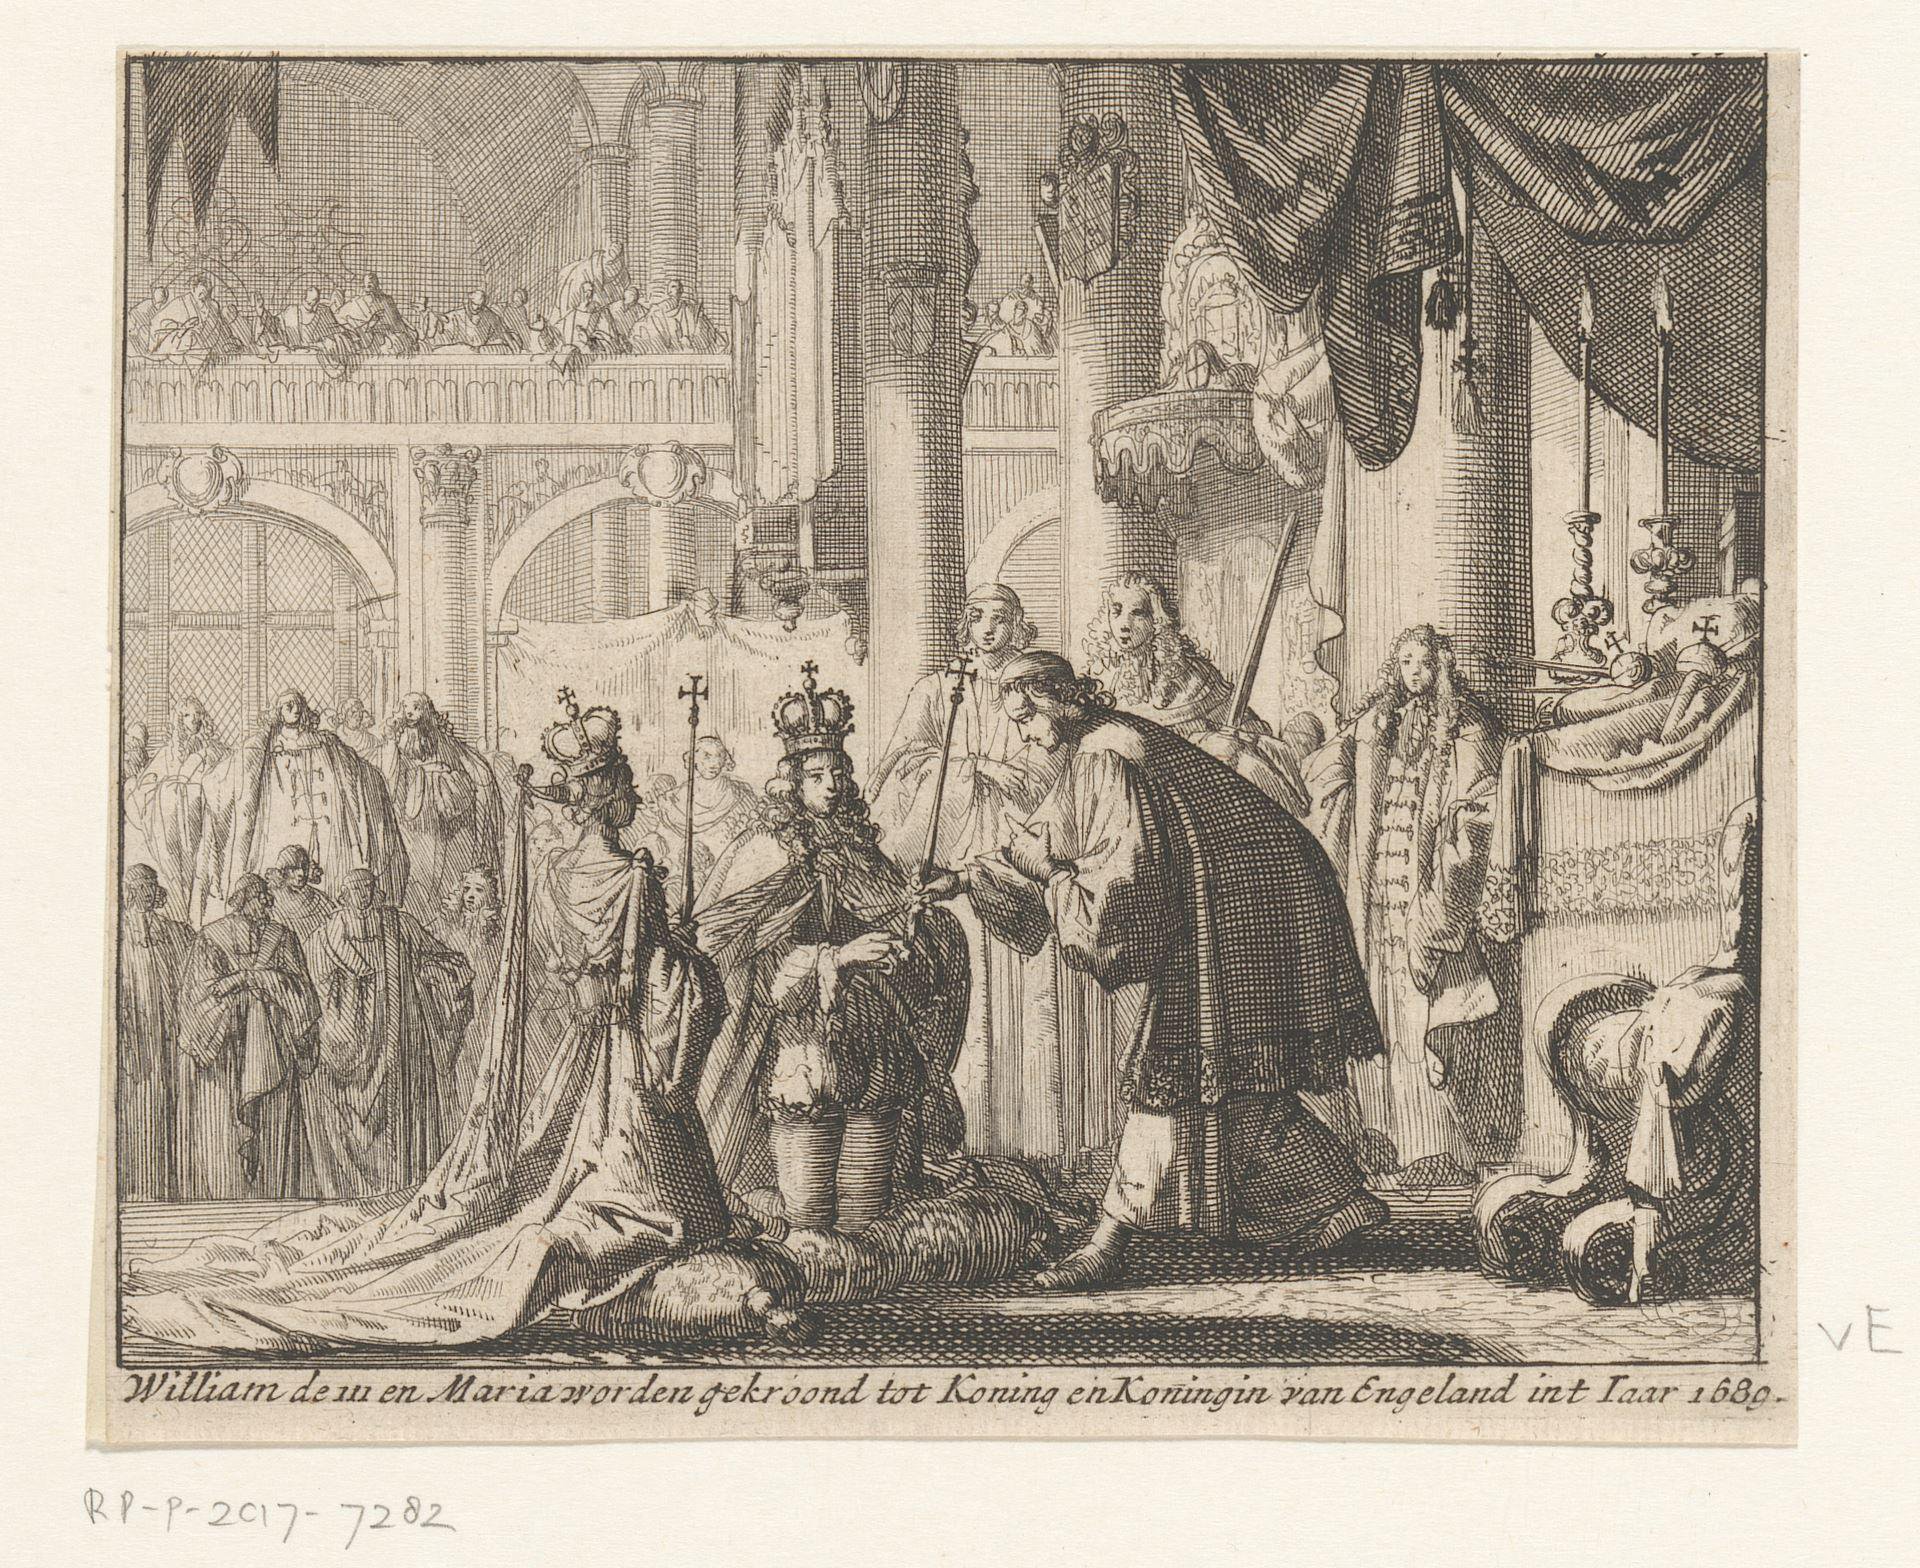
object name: book illustration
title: Kroning van Willem III en Maria II, 1689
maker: jan luyken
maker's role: draughtsman, print maker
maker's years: 1649-1712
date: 1689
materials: paper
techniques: etching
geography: northern netherlands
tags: the hague, william iii (prince of orange and king of england, scotland, and ireland), london, maria ii stuart (koningin van engeland, schotland en ierland), during the coronation, westminster abbey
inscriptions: collector's mark: Lugt 2228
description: Illustratie uit: Pers, Dirck Pietersz. Romeynschen adelaer, waer in de loffelĳcke en lasterlĳcke daden der Romeynsche koningen, en keyseren, verhandelt werden, 3 delen. Utrecht: Jurriaen van Poolsum, 1689, fol. 897. Deze prent is ook genummerd FMH 2696 als illustratie voor: Lambert van den Bosch, Het leven en bedryf van Willem de Darde, Jan Claesz ten Hoorn, Amsterdam 1694, 4 delen.